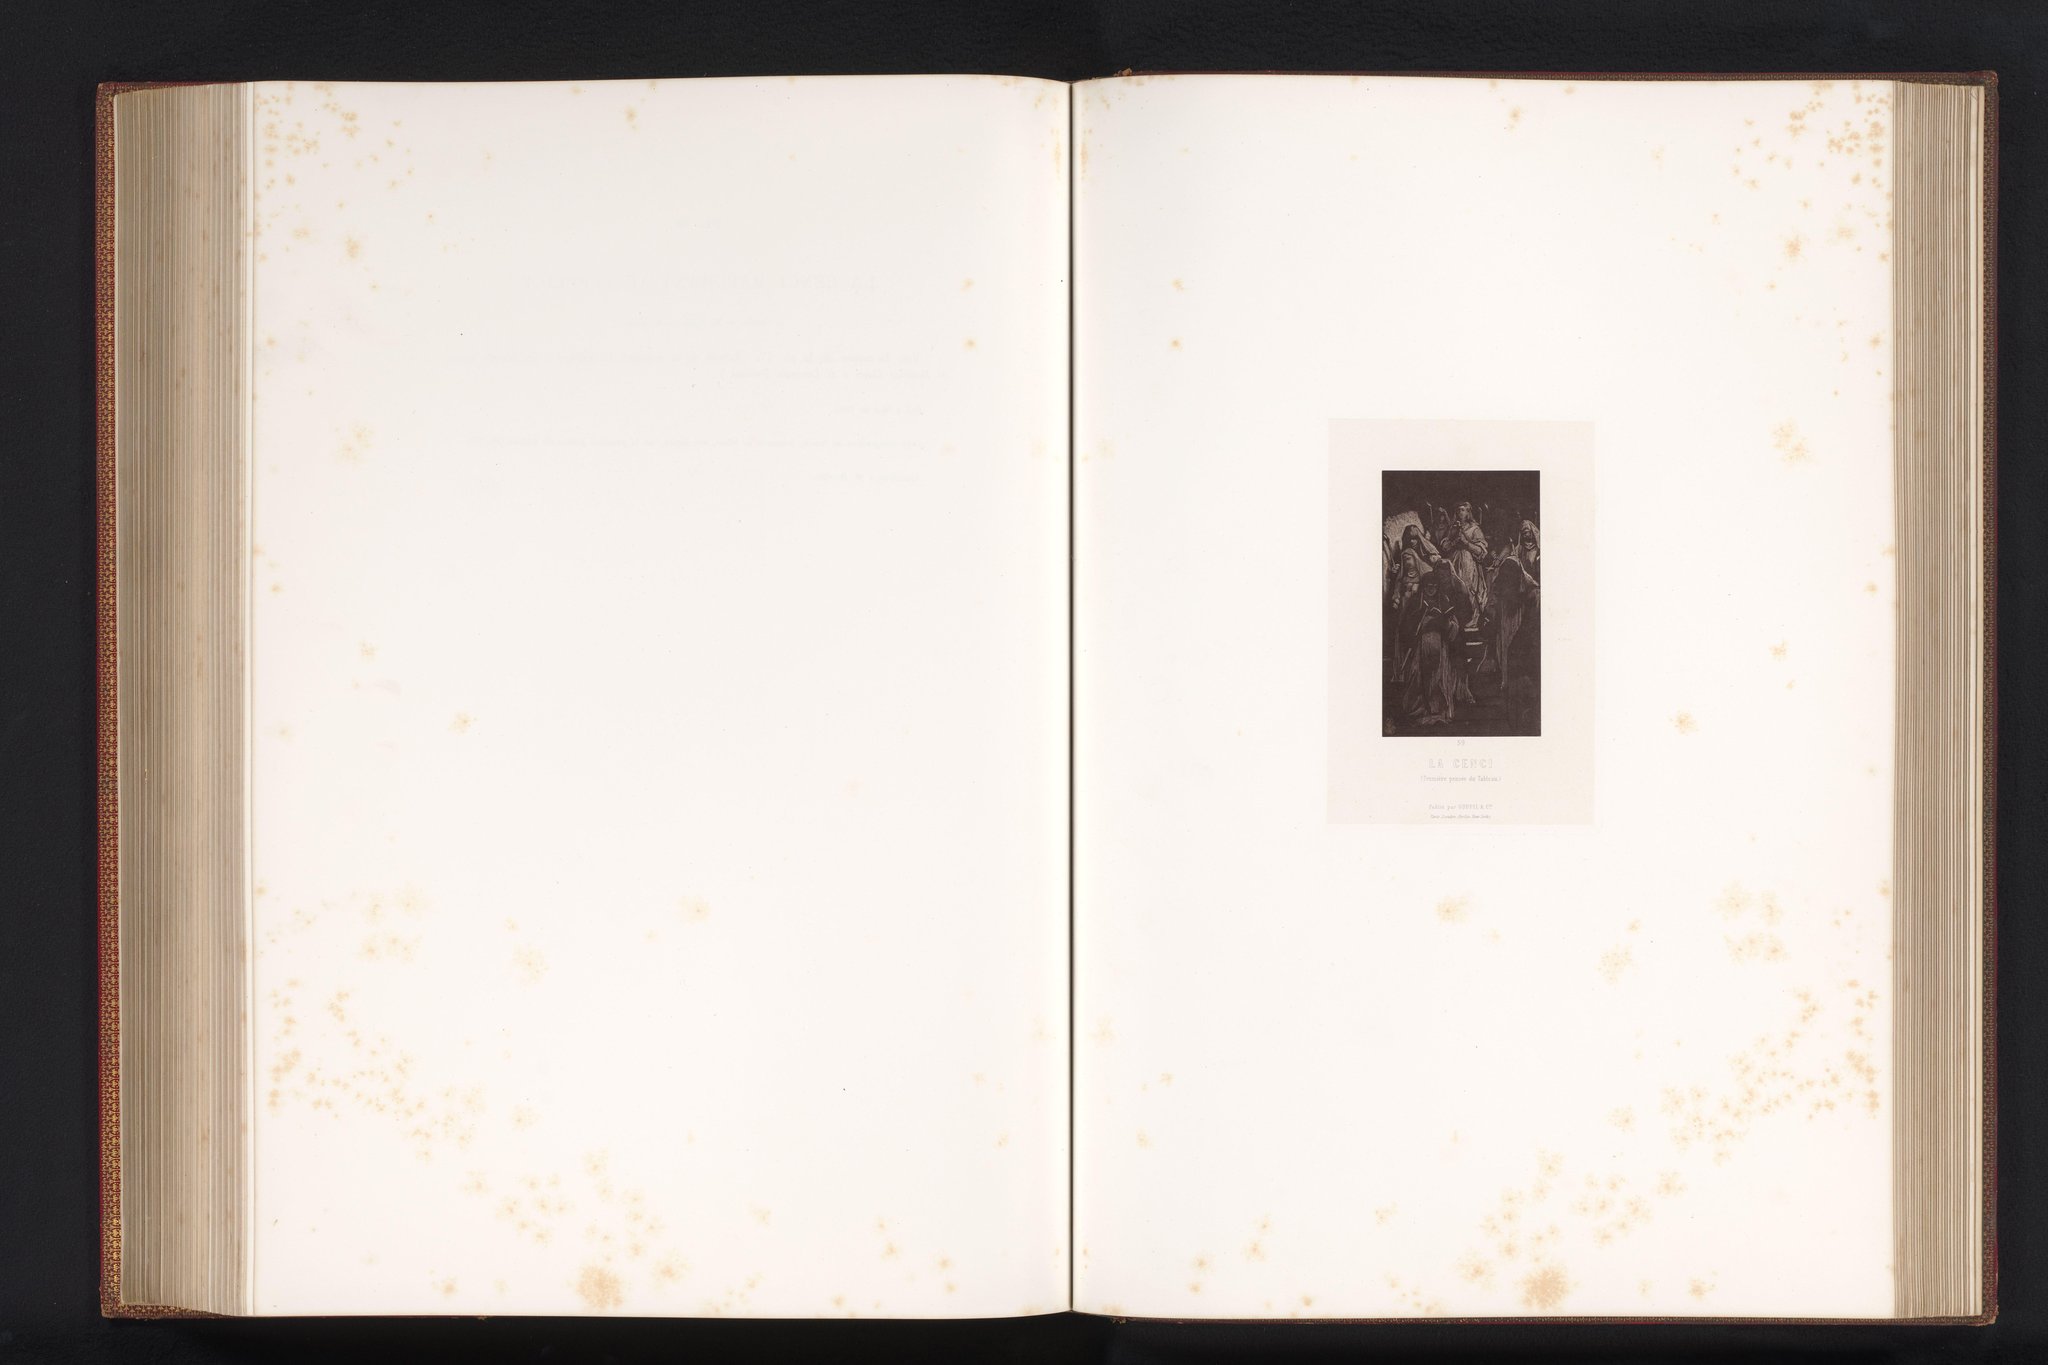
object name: page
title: Fotoreproductie van een tekening van Beatrice Cenci op weg naar haar executie door Paul Delaroche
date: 1853-1858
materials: paper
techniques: albumen print, engraving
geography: paris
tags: (public) prayer, procession ~ christian religion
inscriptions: initials: ‘GC’